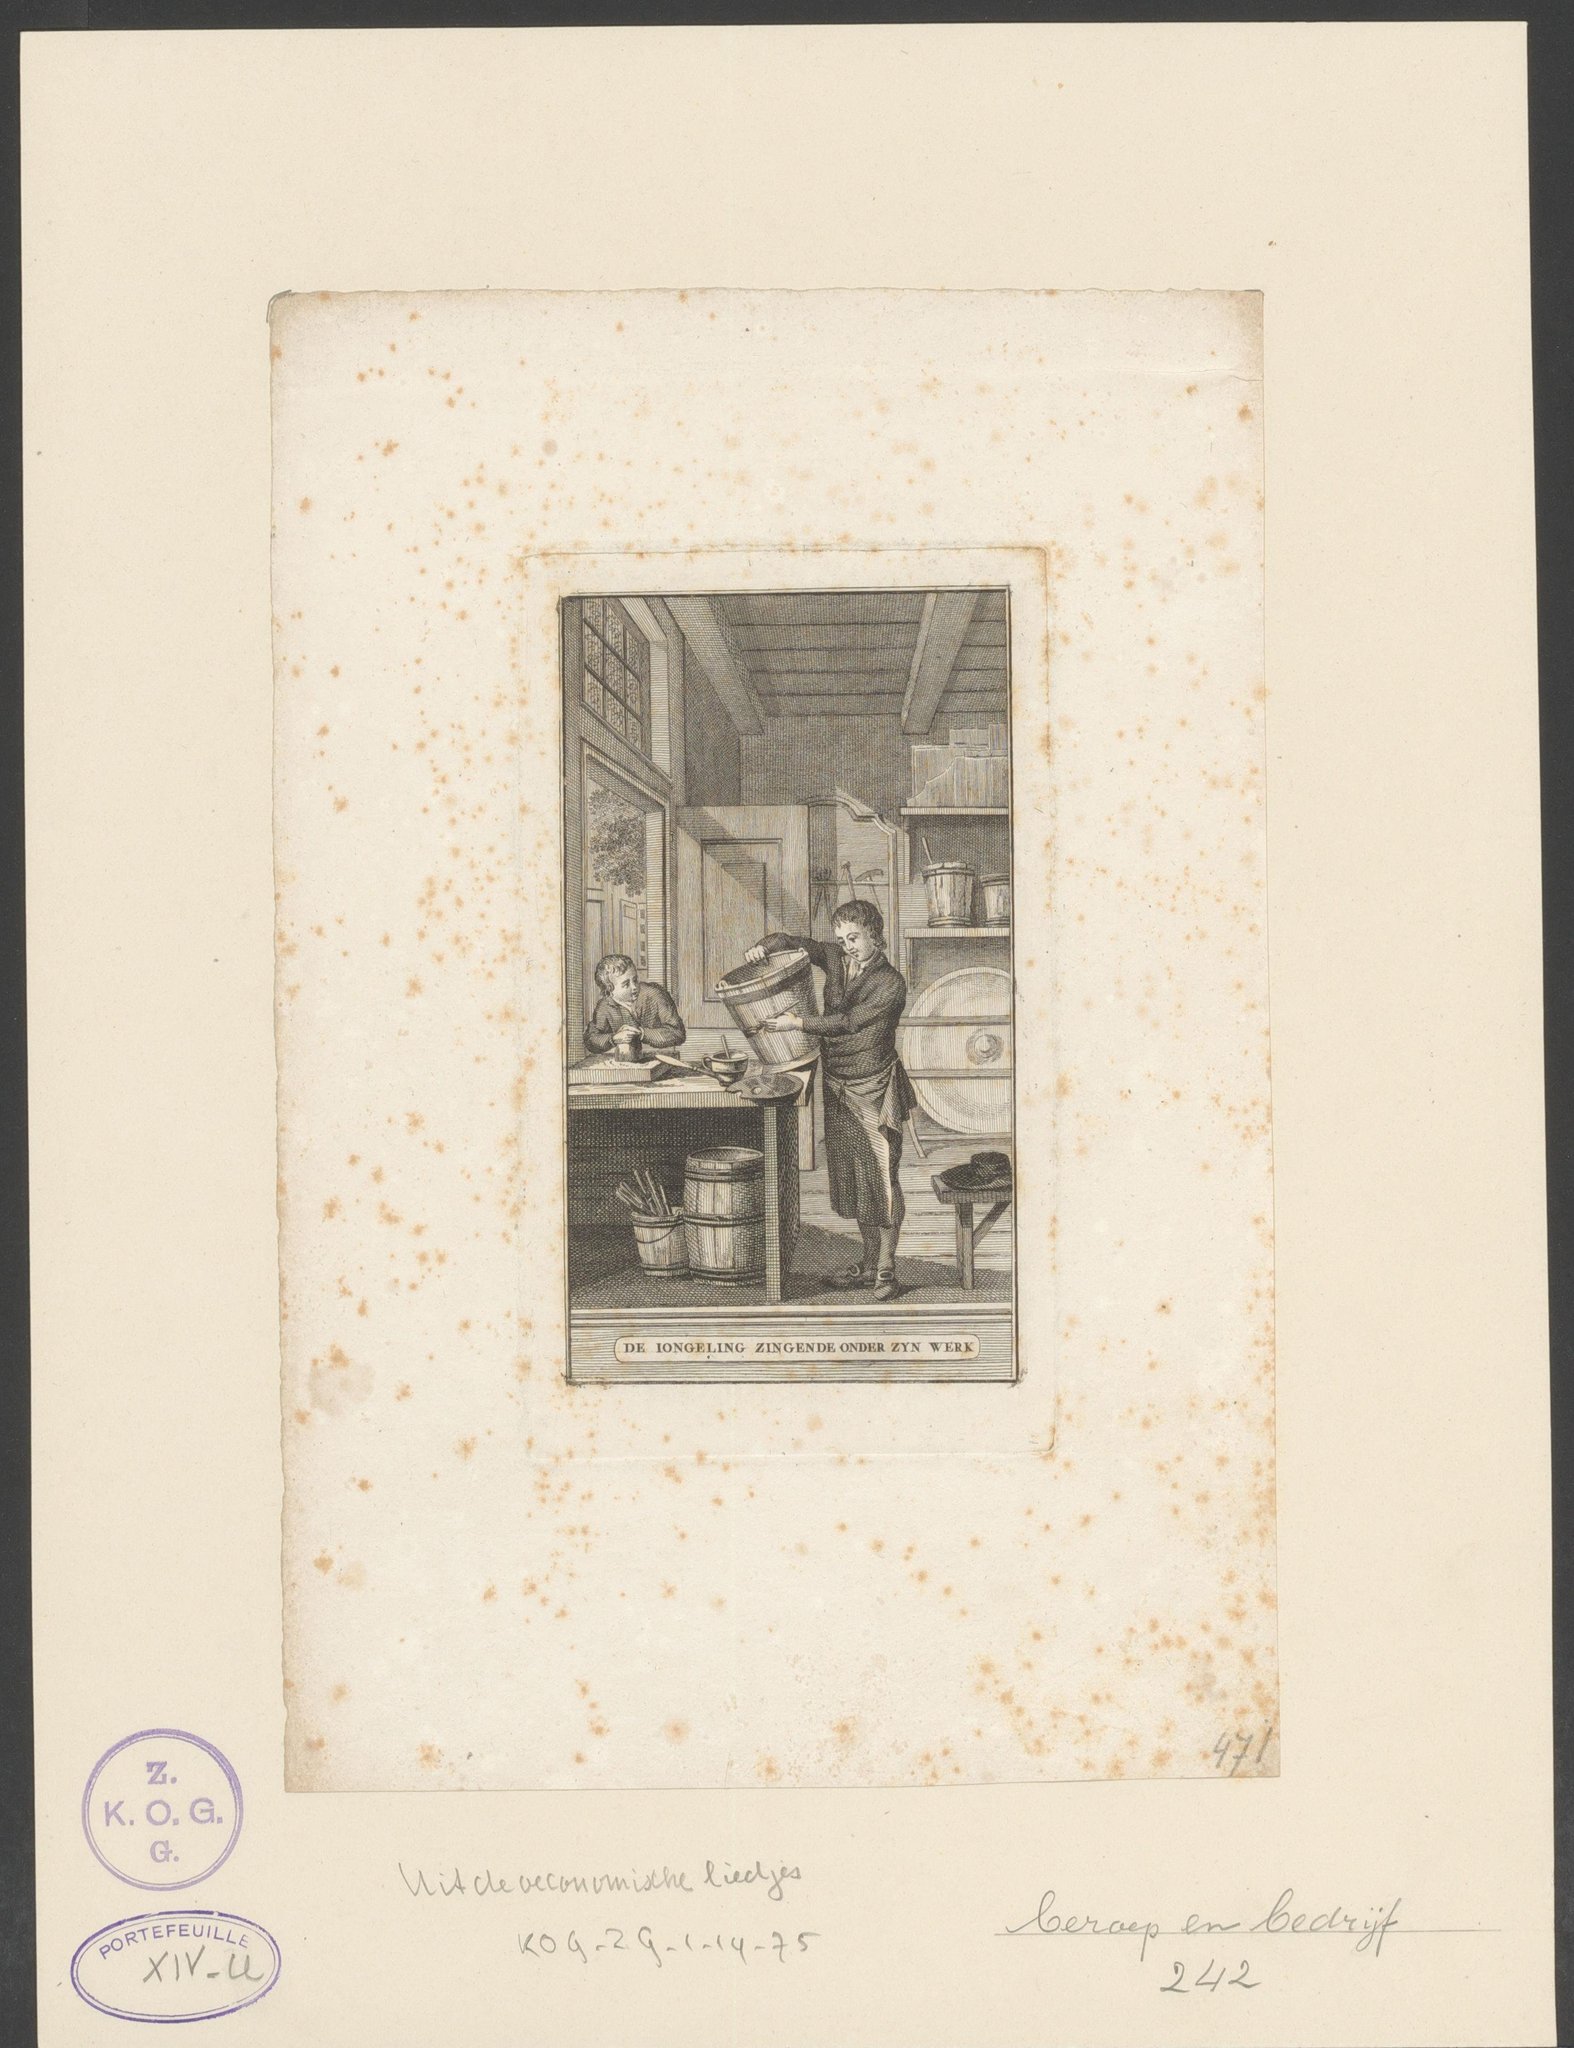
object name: print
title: De Iongeling zingende onder zyn werk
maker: Anonymous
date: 1792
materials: paper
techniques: engraving, etching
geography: netherlands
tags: handicrafts, craftsman at work, singer without accompaniment, painter at work, in his studio, painter preparing colours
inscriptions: collector's mark, collector's mark: Lugt 1641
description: Een schilder bezig in zijn werkplaats met het beschilderen van een houten emmer. Links een jongen die pigmenten maalt. Onderwerpsrubrieken binnen de Atlas Zeden en Gewoonten: Mannelijk beroep en bedrijf: Schilders.